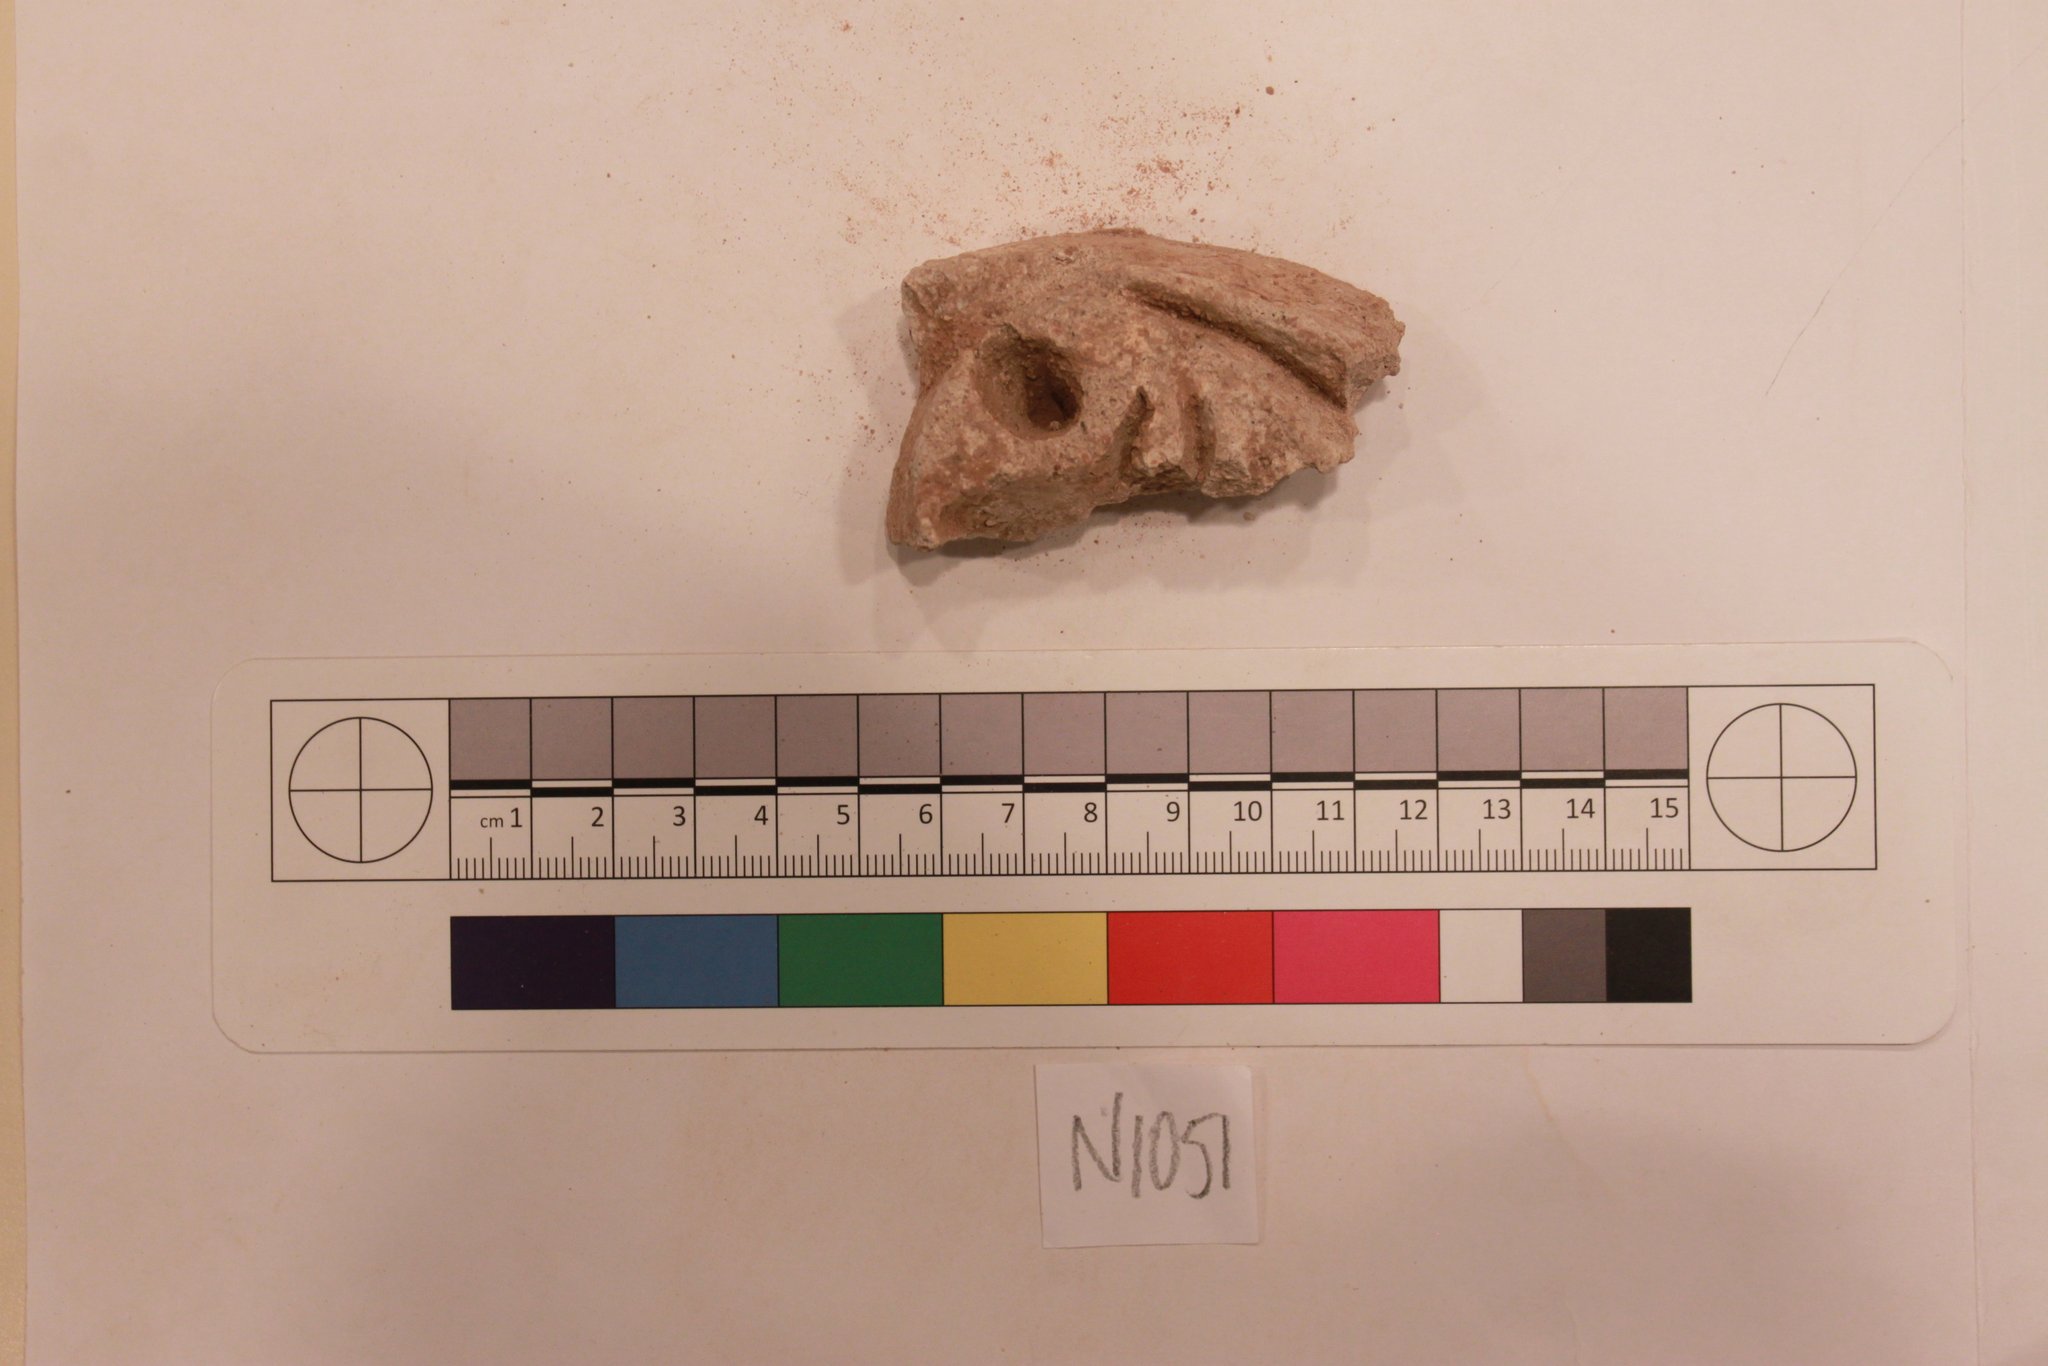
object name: fragment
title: Stucco Fragment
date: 701-1200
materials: plaster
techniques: carving, painting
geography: iran